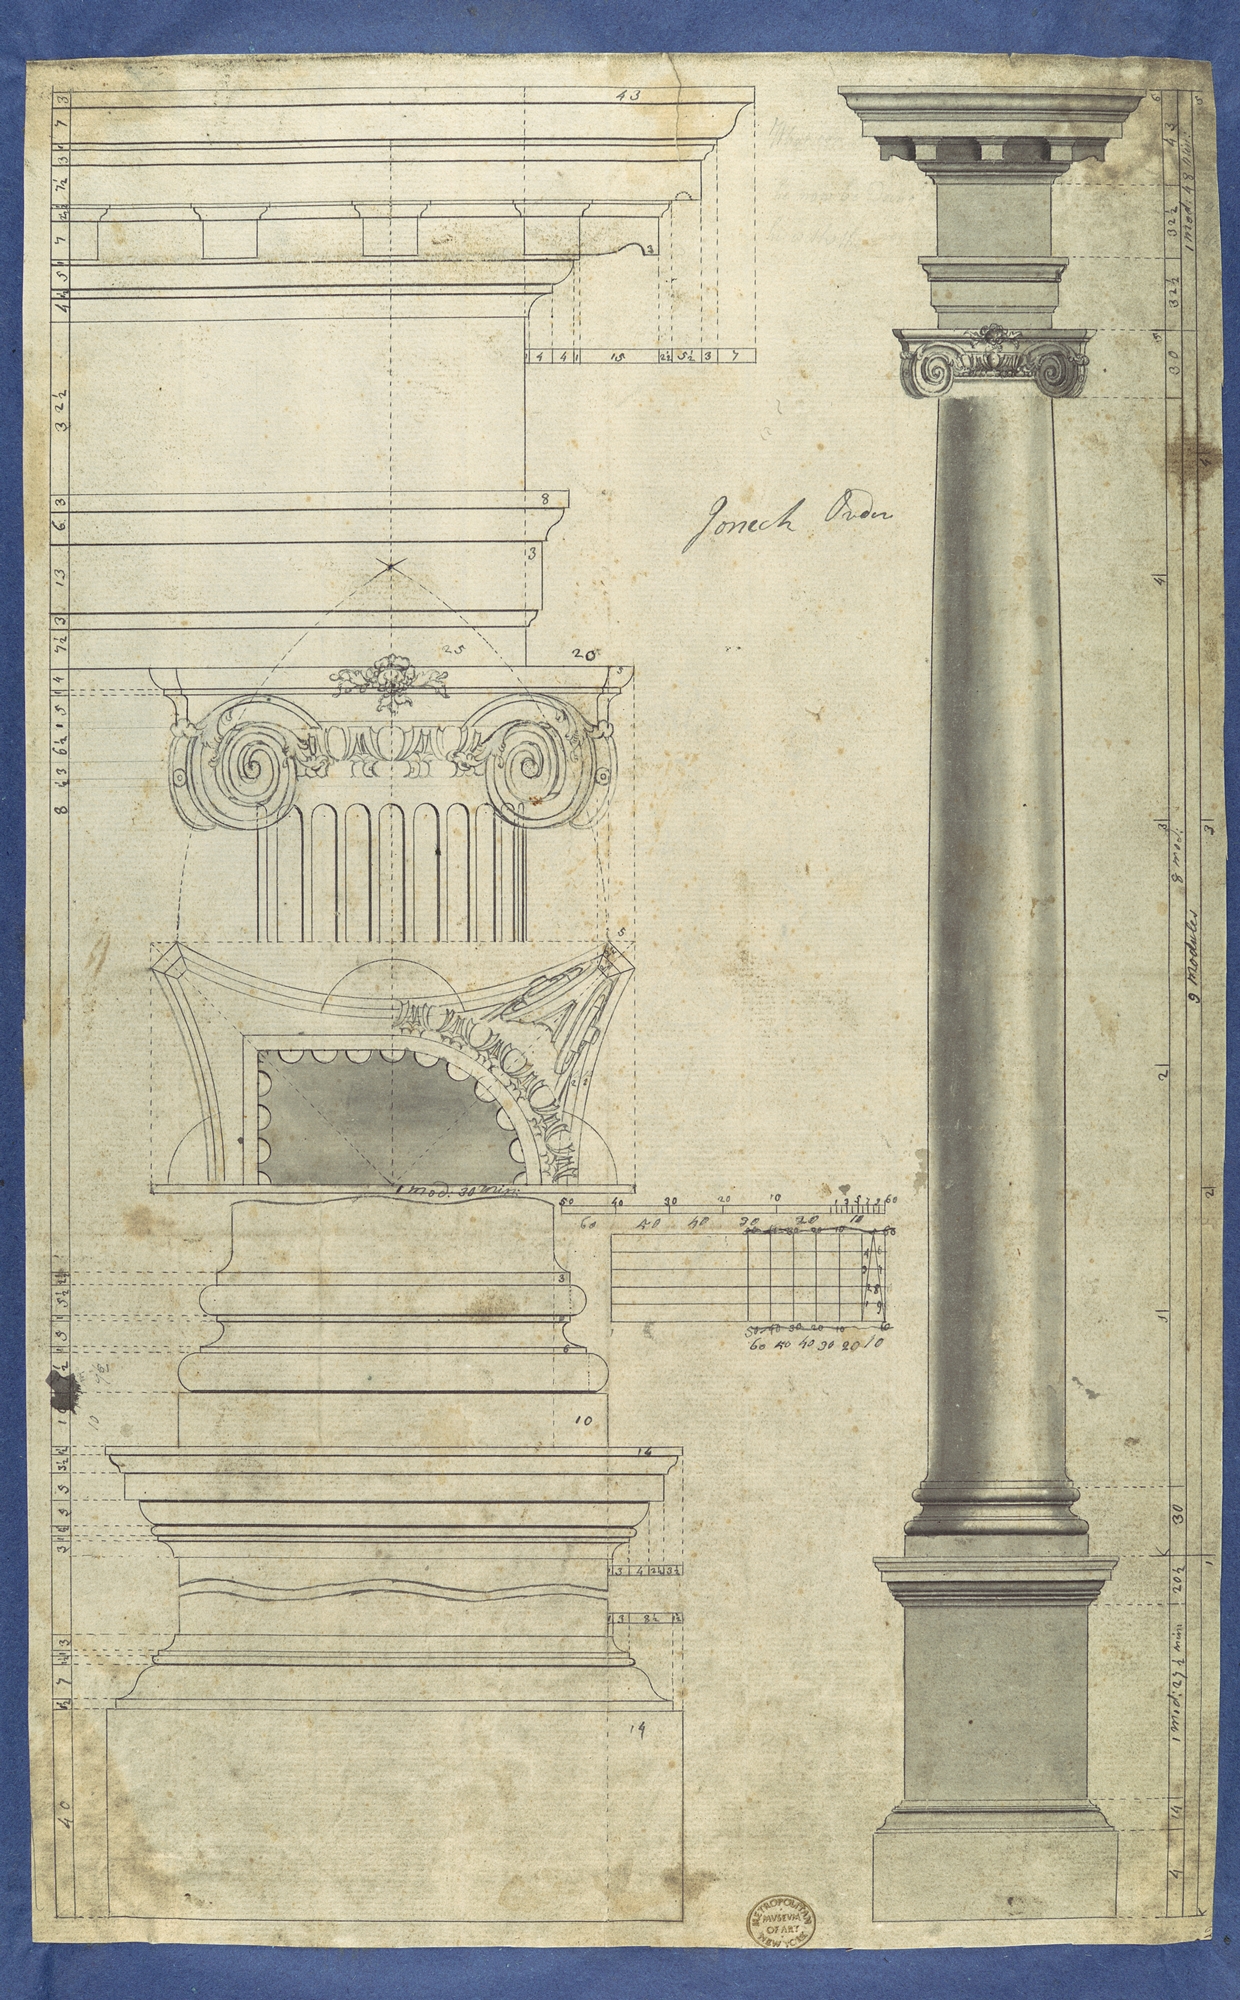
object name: drawing ornament architecture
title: The General Proportion of the Ionick [Ionic] Order, in Chippendale Drawings, Vol. I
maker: thomas chippendale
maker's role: artist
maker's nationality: british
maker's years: 1718-1779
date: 1753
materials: ink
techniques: wash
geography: london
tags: columns